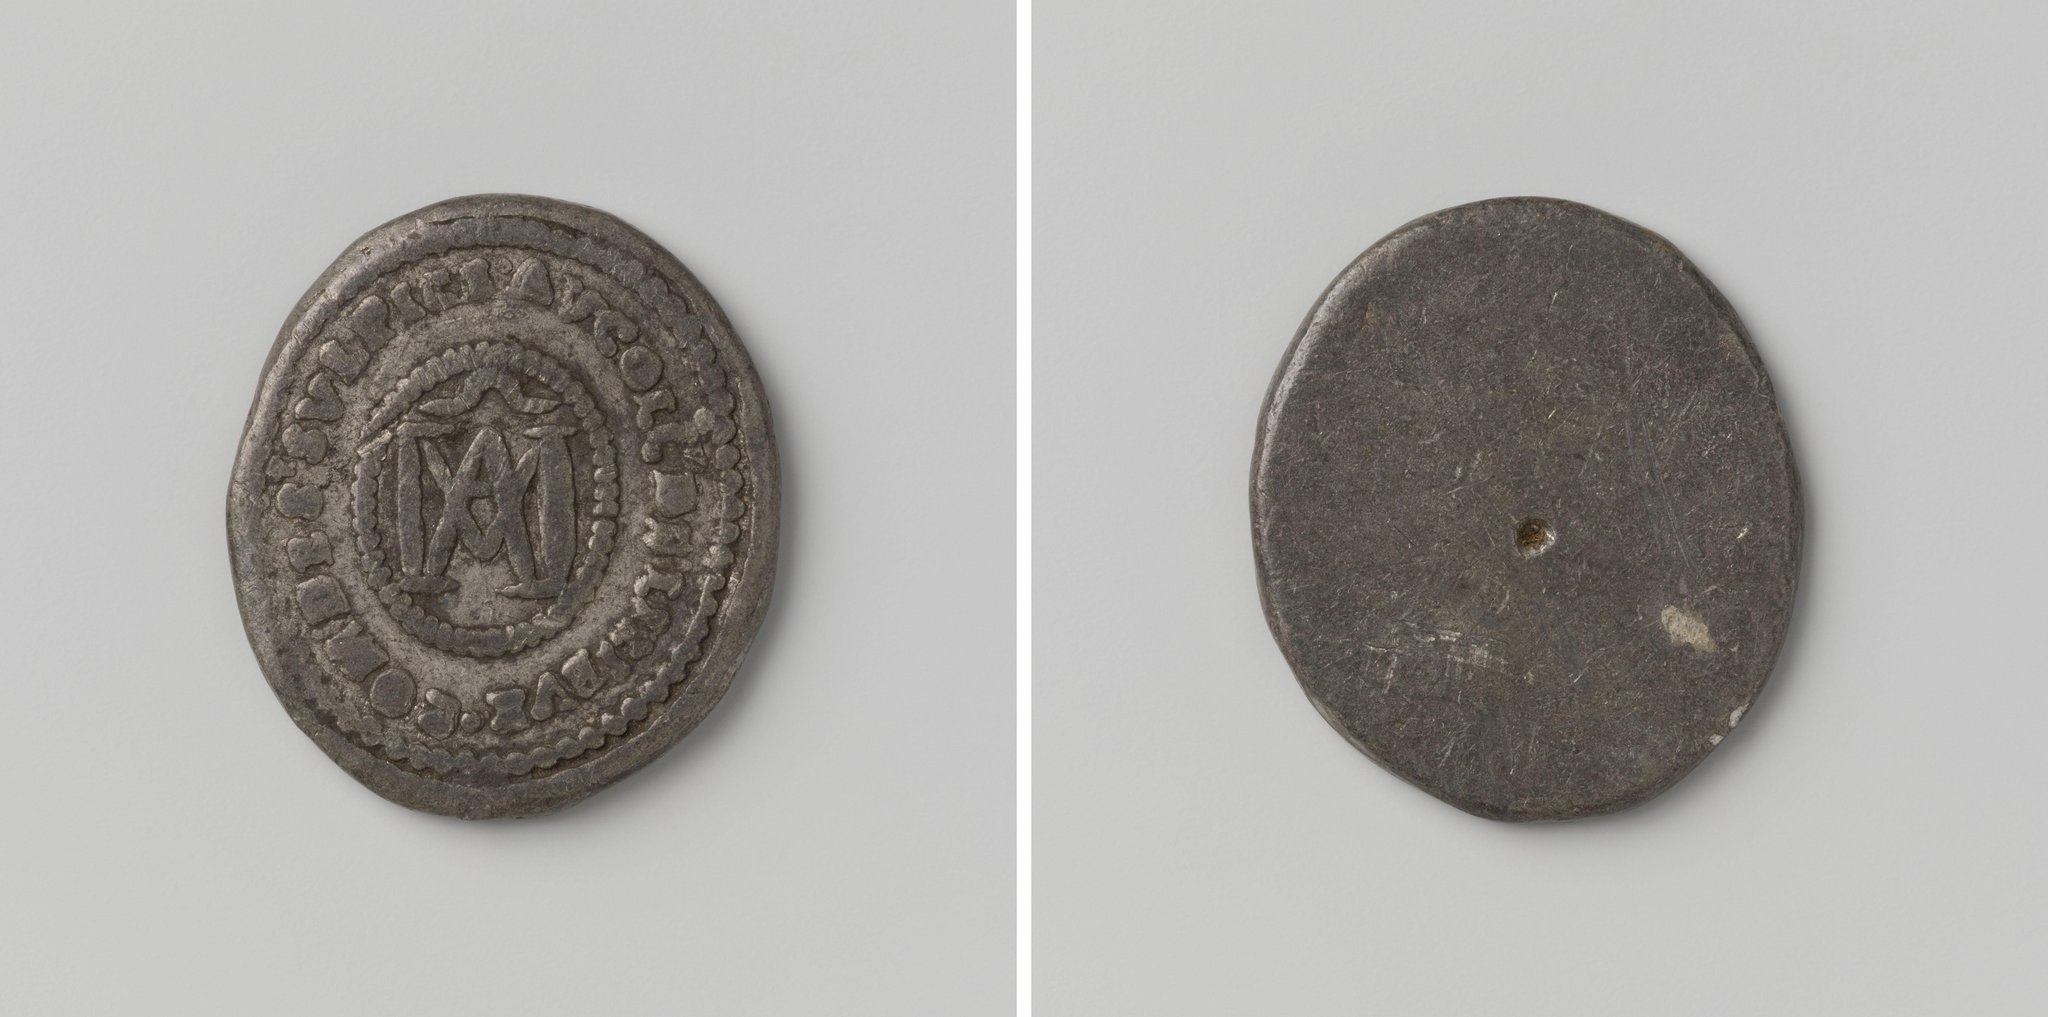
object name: devotional medal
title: Penning met Maria-monogram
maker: Anonymous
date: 1600-1800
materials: lead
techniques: casting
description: Eenzijdige, ovale loden penning. Voorzijde: monogram van letters M en A binnen parelrand, omschrift en tweede parelrand. Keerzijde: blanco. Vermoedelijk een religieuze penning.